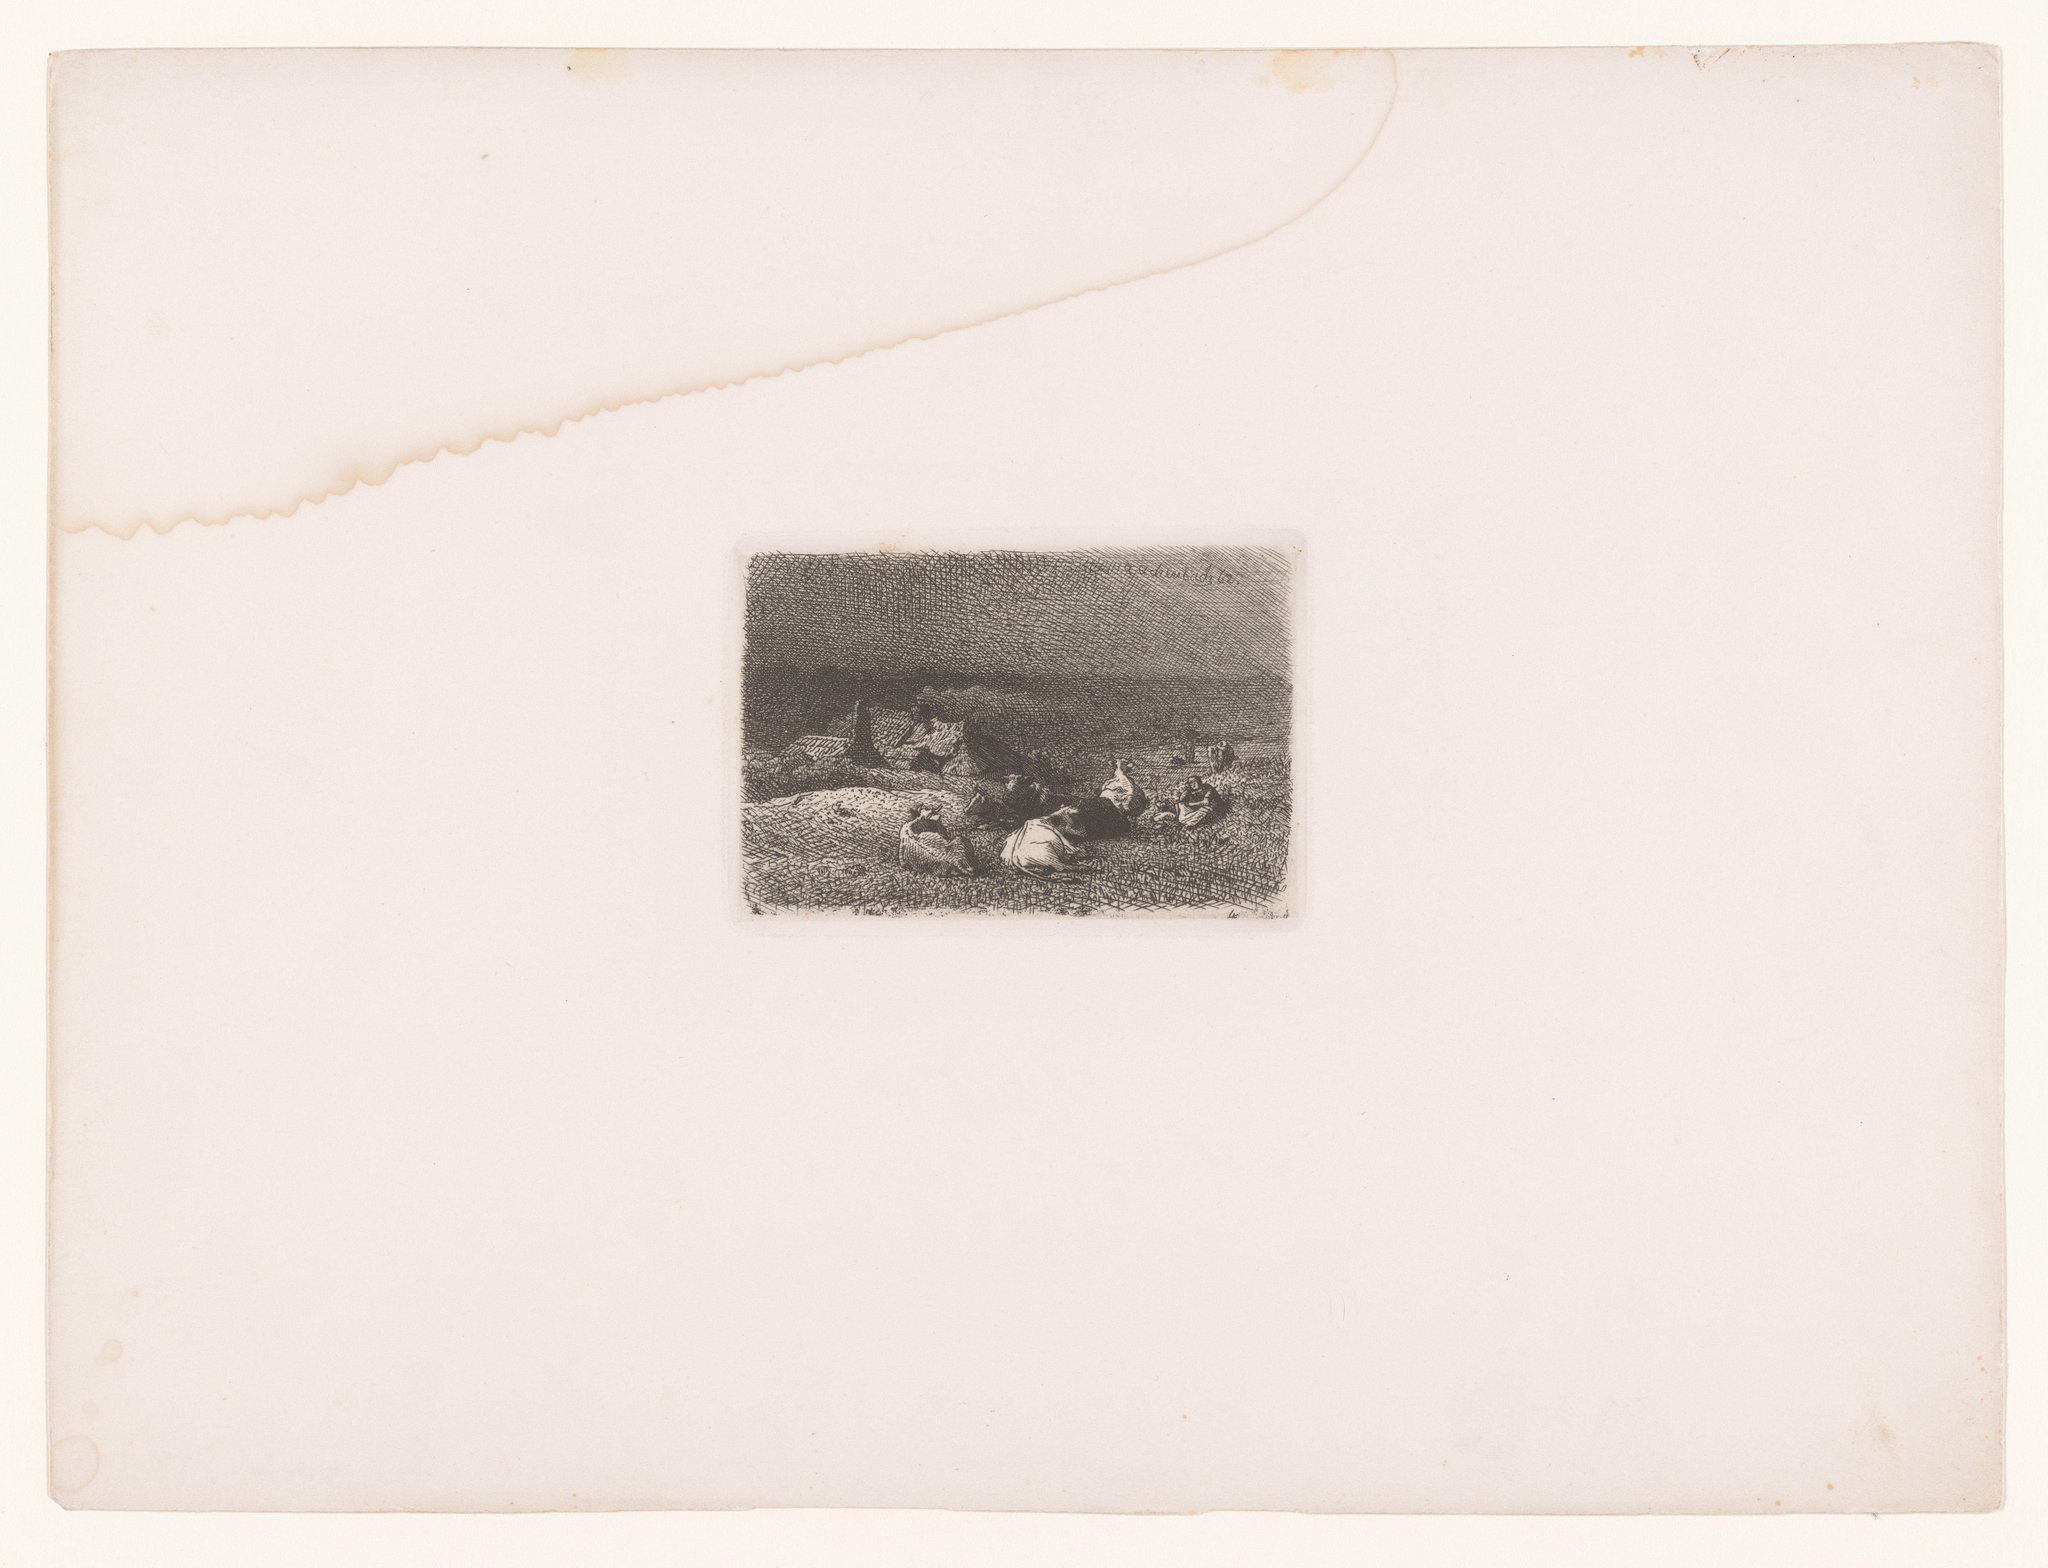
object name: print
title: Landschappen en zeegezichten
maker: andreas achenbach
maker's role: print maker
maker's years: 1815-1910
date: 1862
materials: paper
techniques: etching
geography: dusseldorf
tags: cow, herding, herdsman, herdswoman, shepherd, shepherdess, cowherd, etc., night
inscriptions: collector's mark: Lugt 2228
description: Deze prent maakt deel uit van een serie van twaalf prenten met landschappen en zeegezichten.